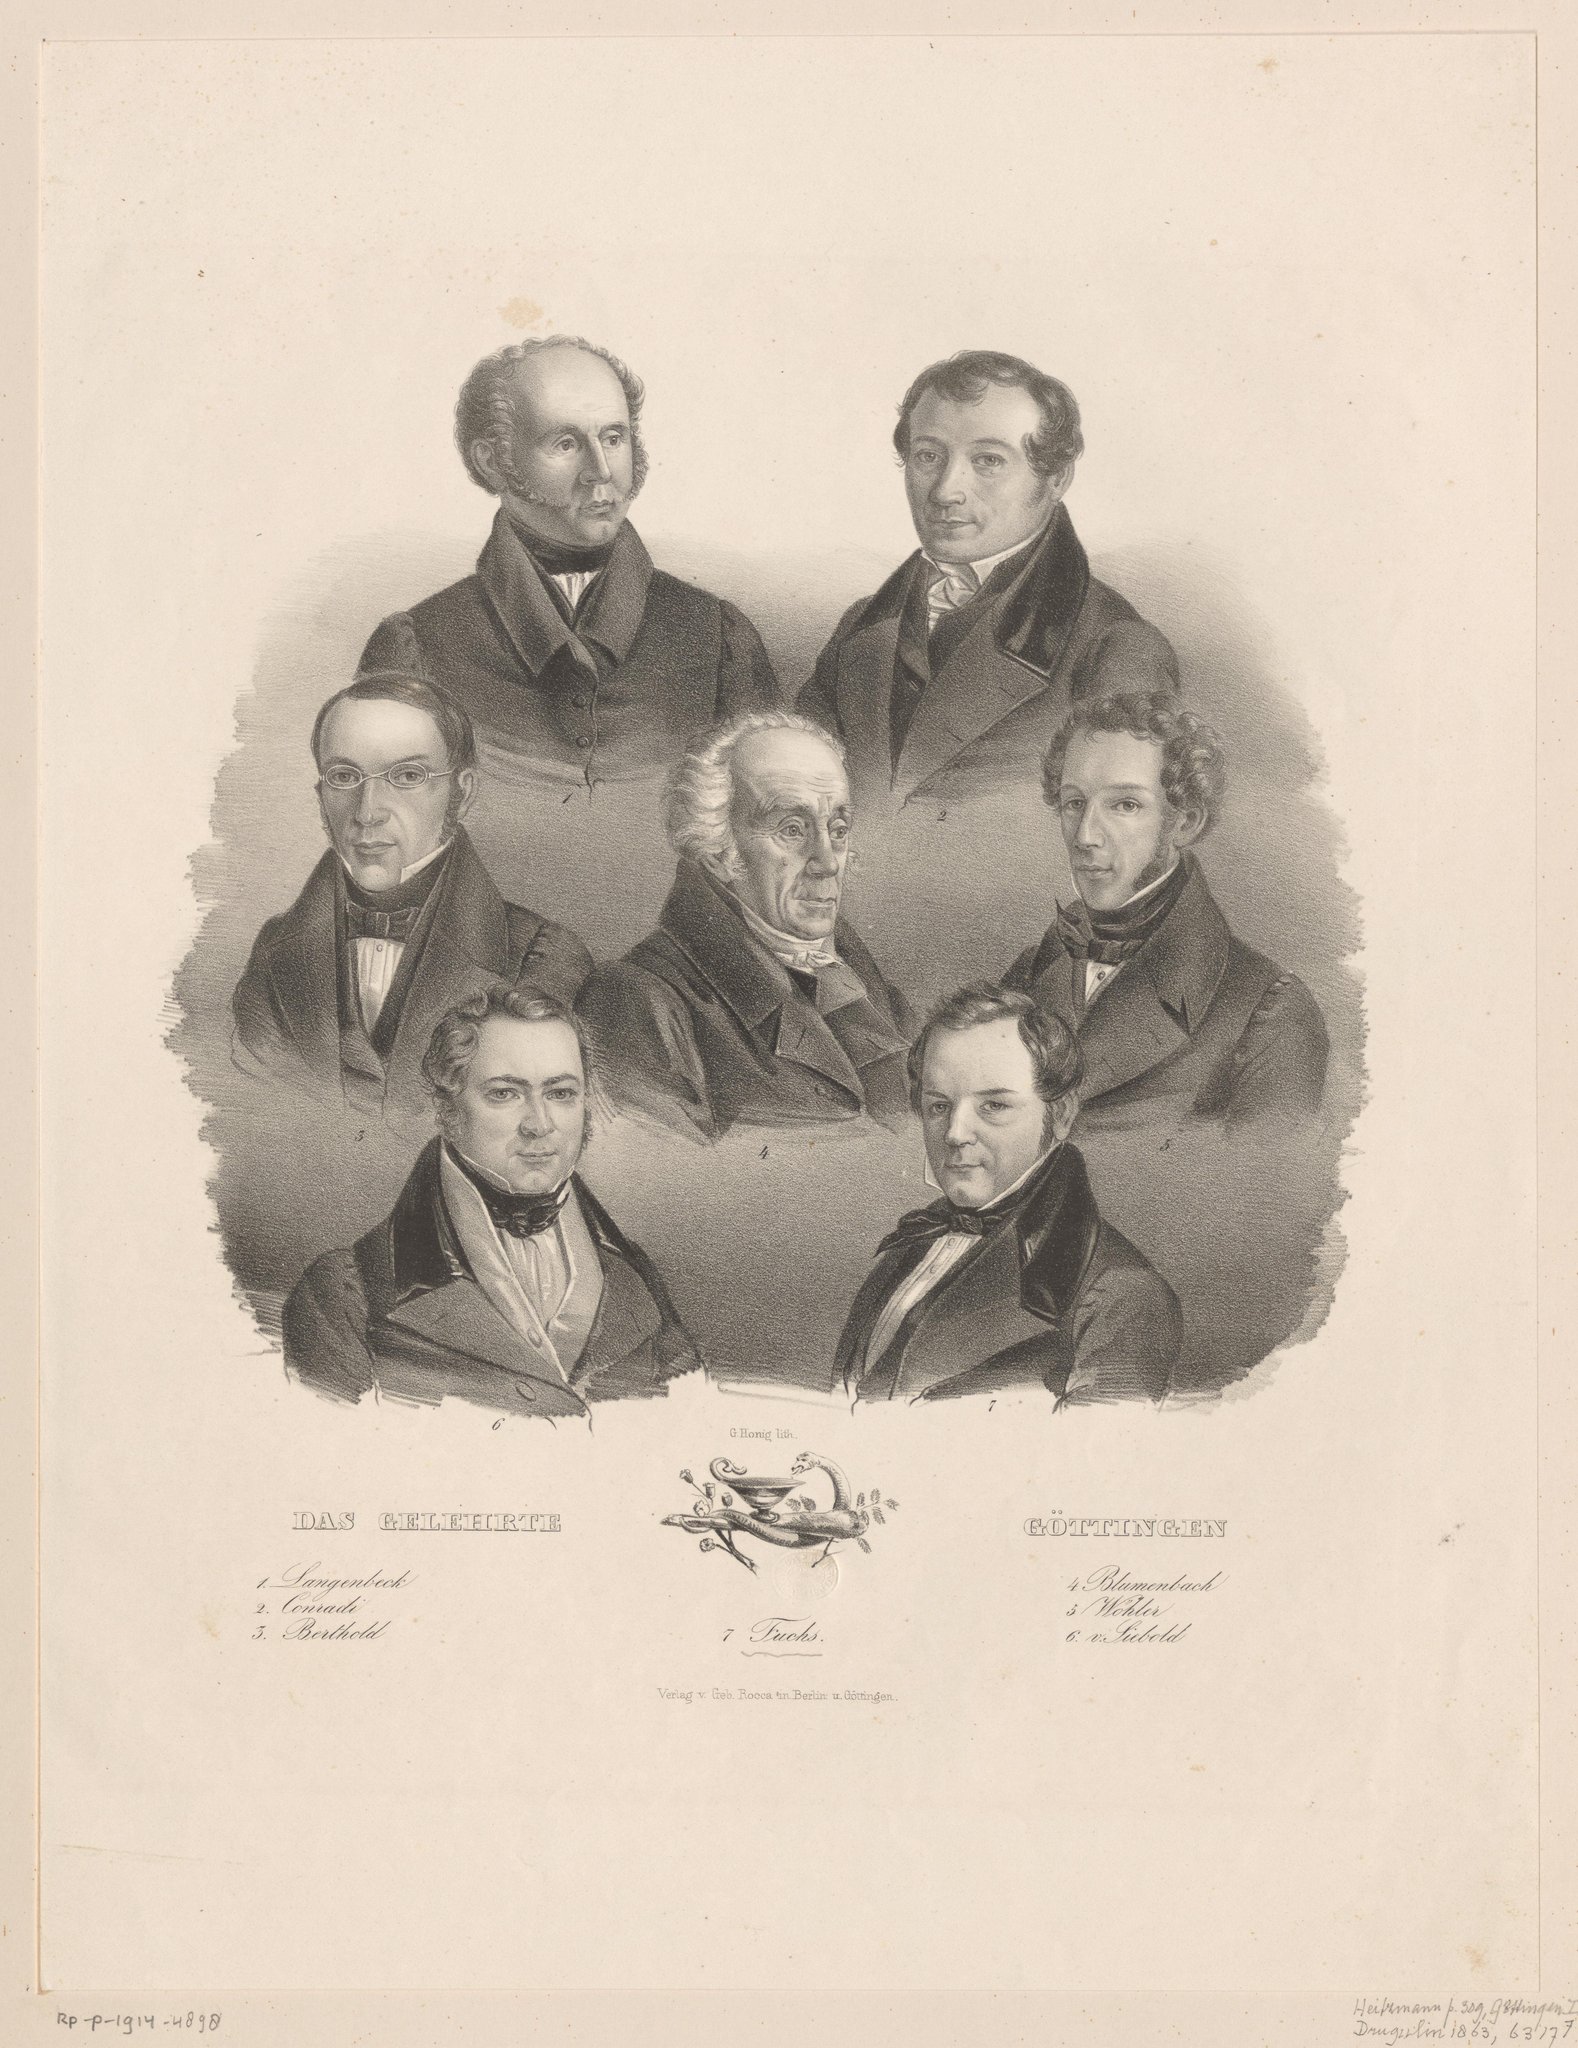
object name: print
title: Das Gelehrte Göttingen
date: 1830-1850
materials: paper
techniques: lithograph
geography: gottingen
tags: physicist, group of scholars or philosophers, historical persons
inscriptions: check stamp: ‘Gebrueder Rocca in Göttingen’, collector's mark: Lugt 2228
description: Portretten van Conrad Johann Martin Langenbeck, Johann Wilhelm Heinrich Conradi, Arnold Adolph Berthold, Johann Friedrich Blumenbach, Friedrich Wöhler, Eduard Caspar Jacob von Siebold en Conrad Heinrich Fuchs. De portretten zijn genummerd 1 t/m 7.